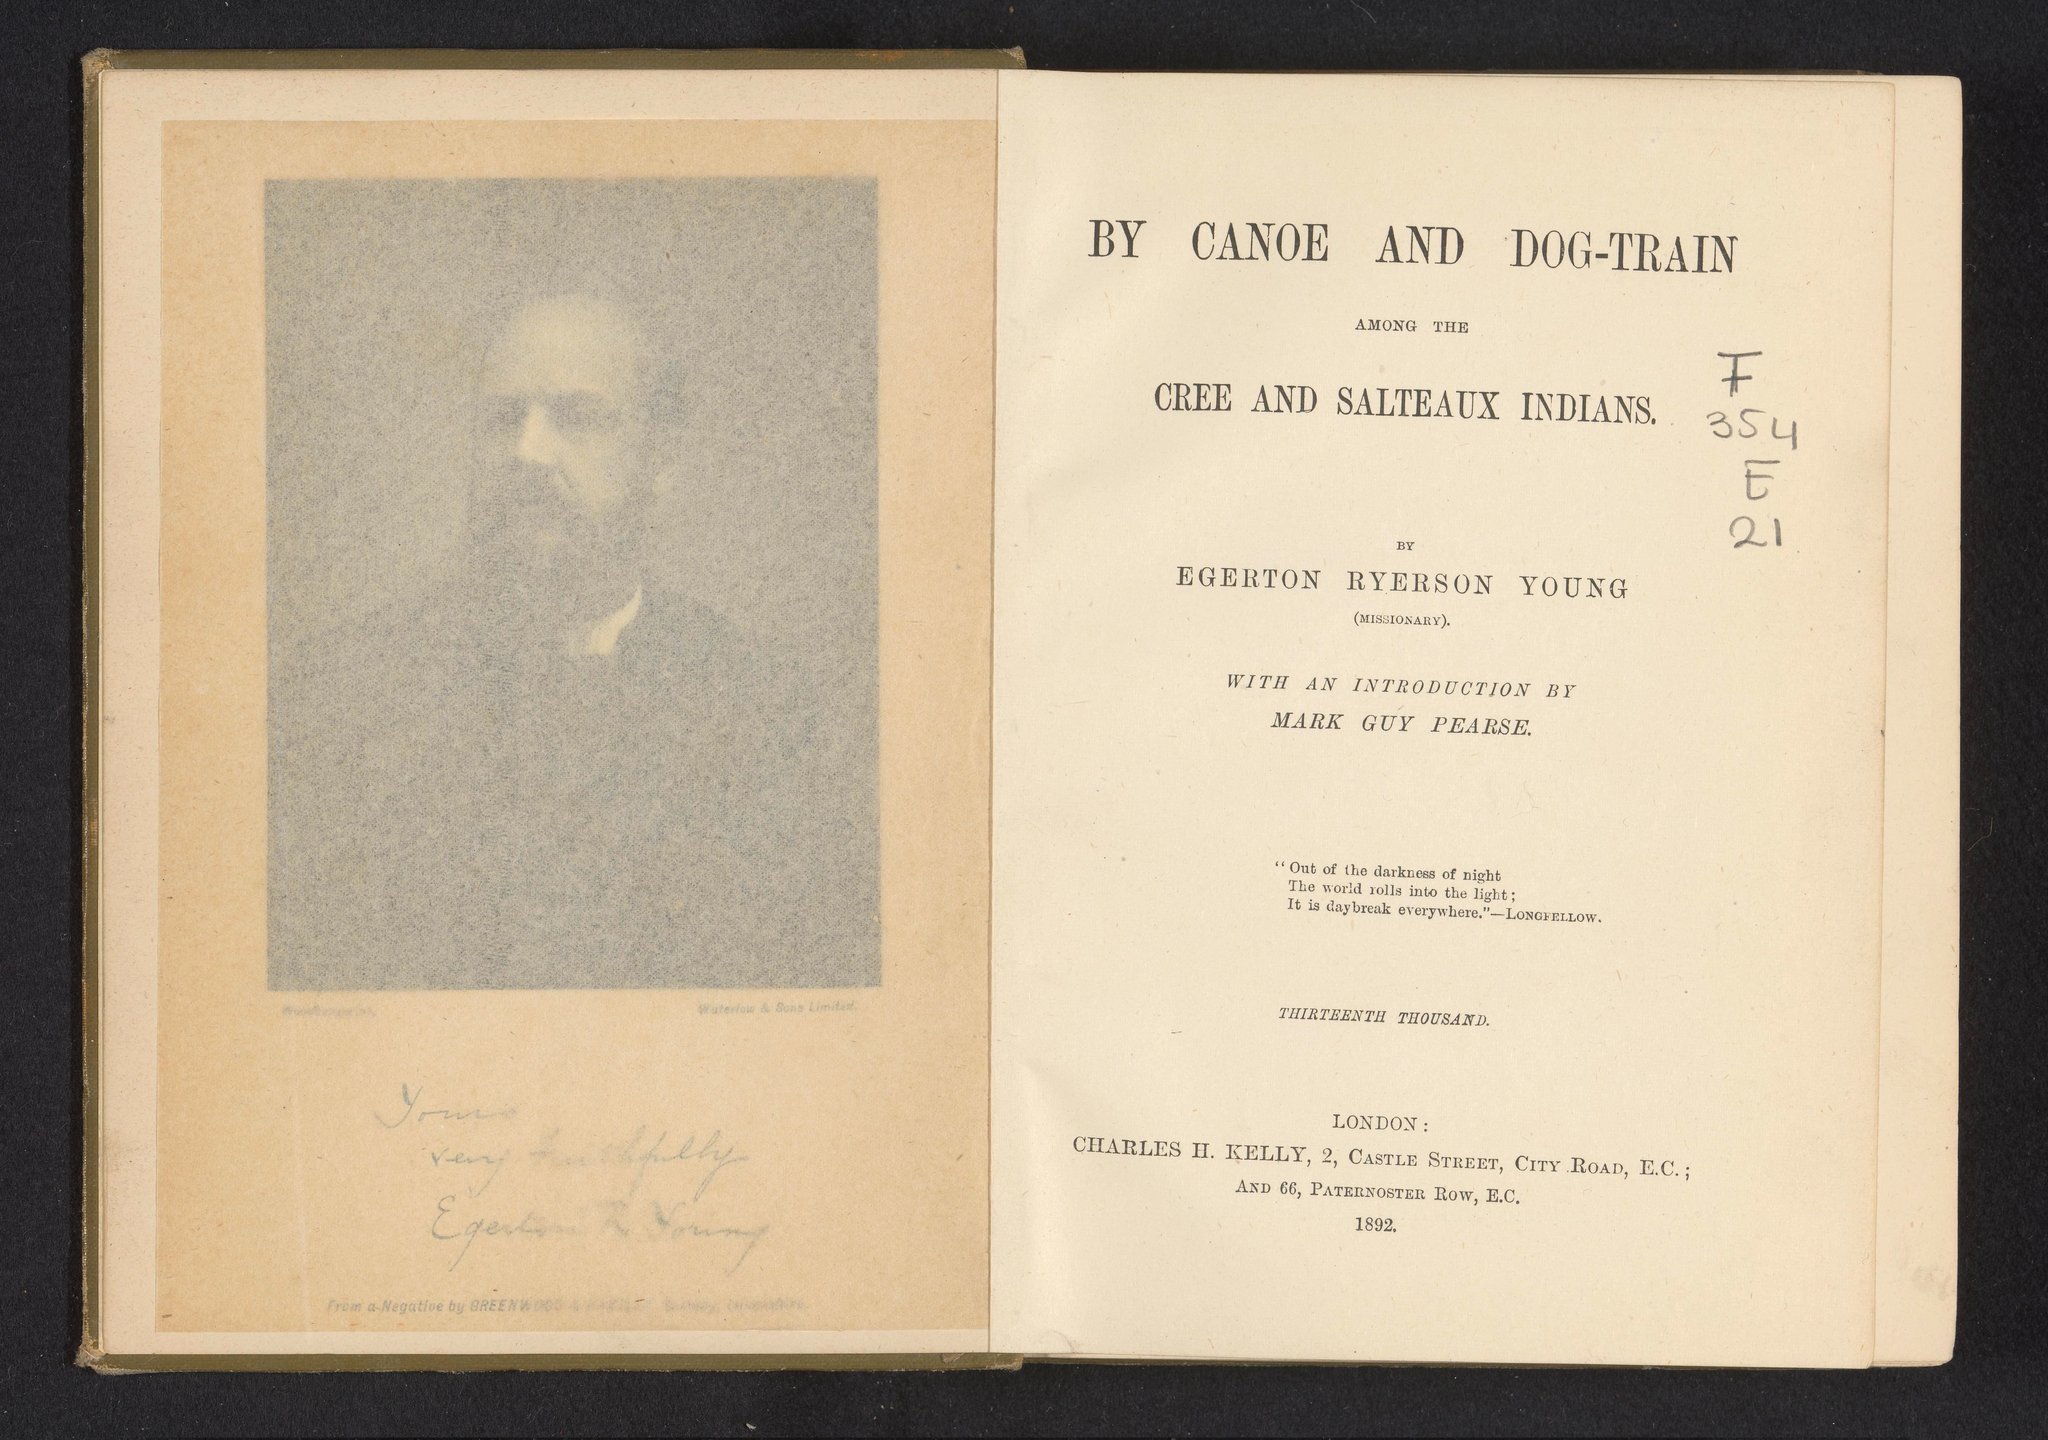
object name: book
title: By Canoe and dog-train among the Cree and Salteaux indians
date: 1892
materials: linen, paper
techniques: printing, woodburytype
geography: london